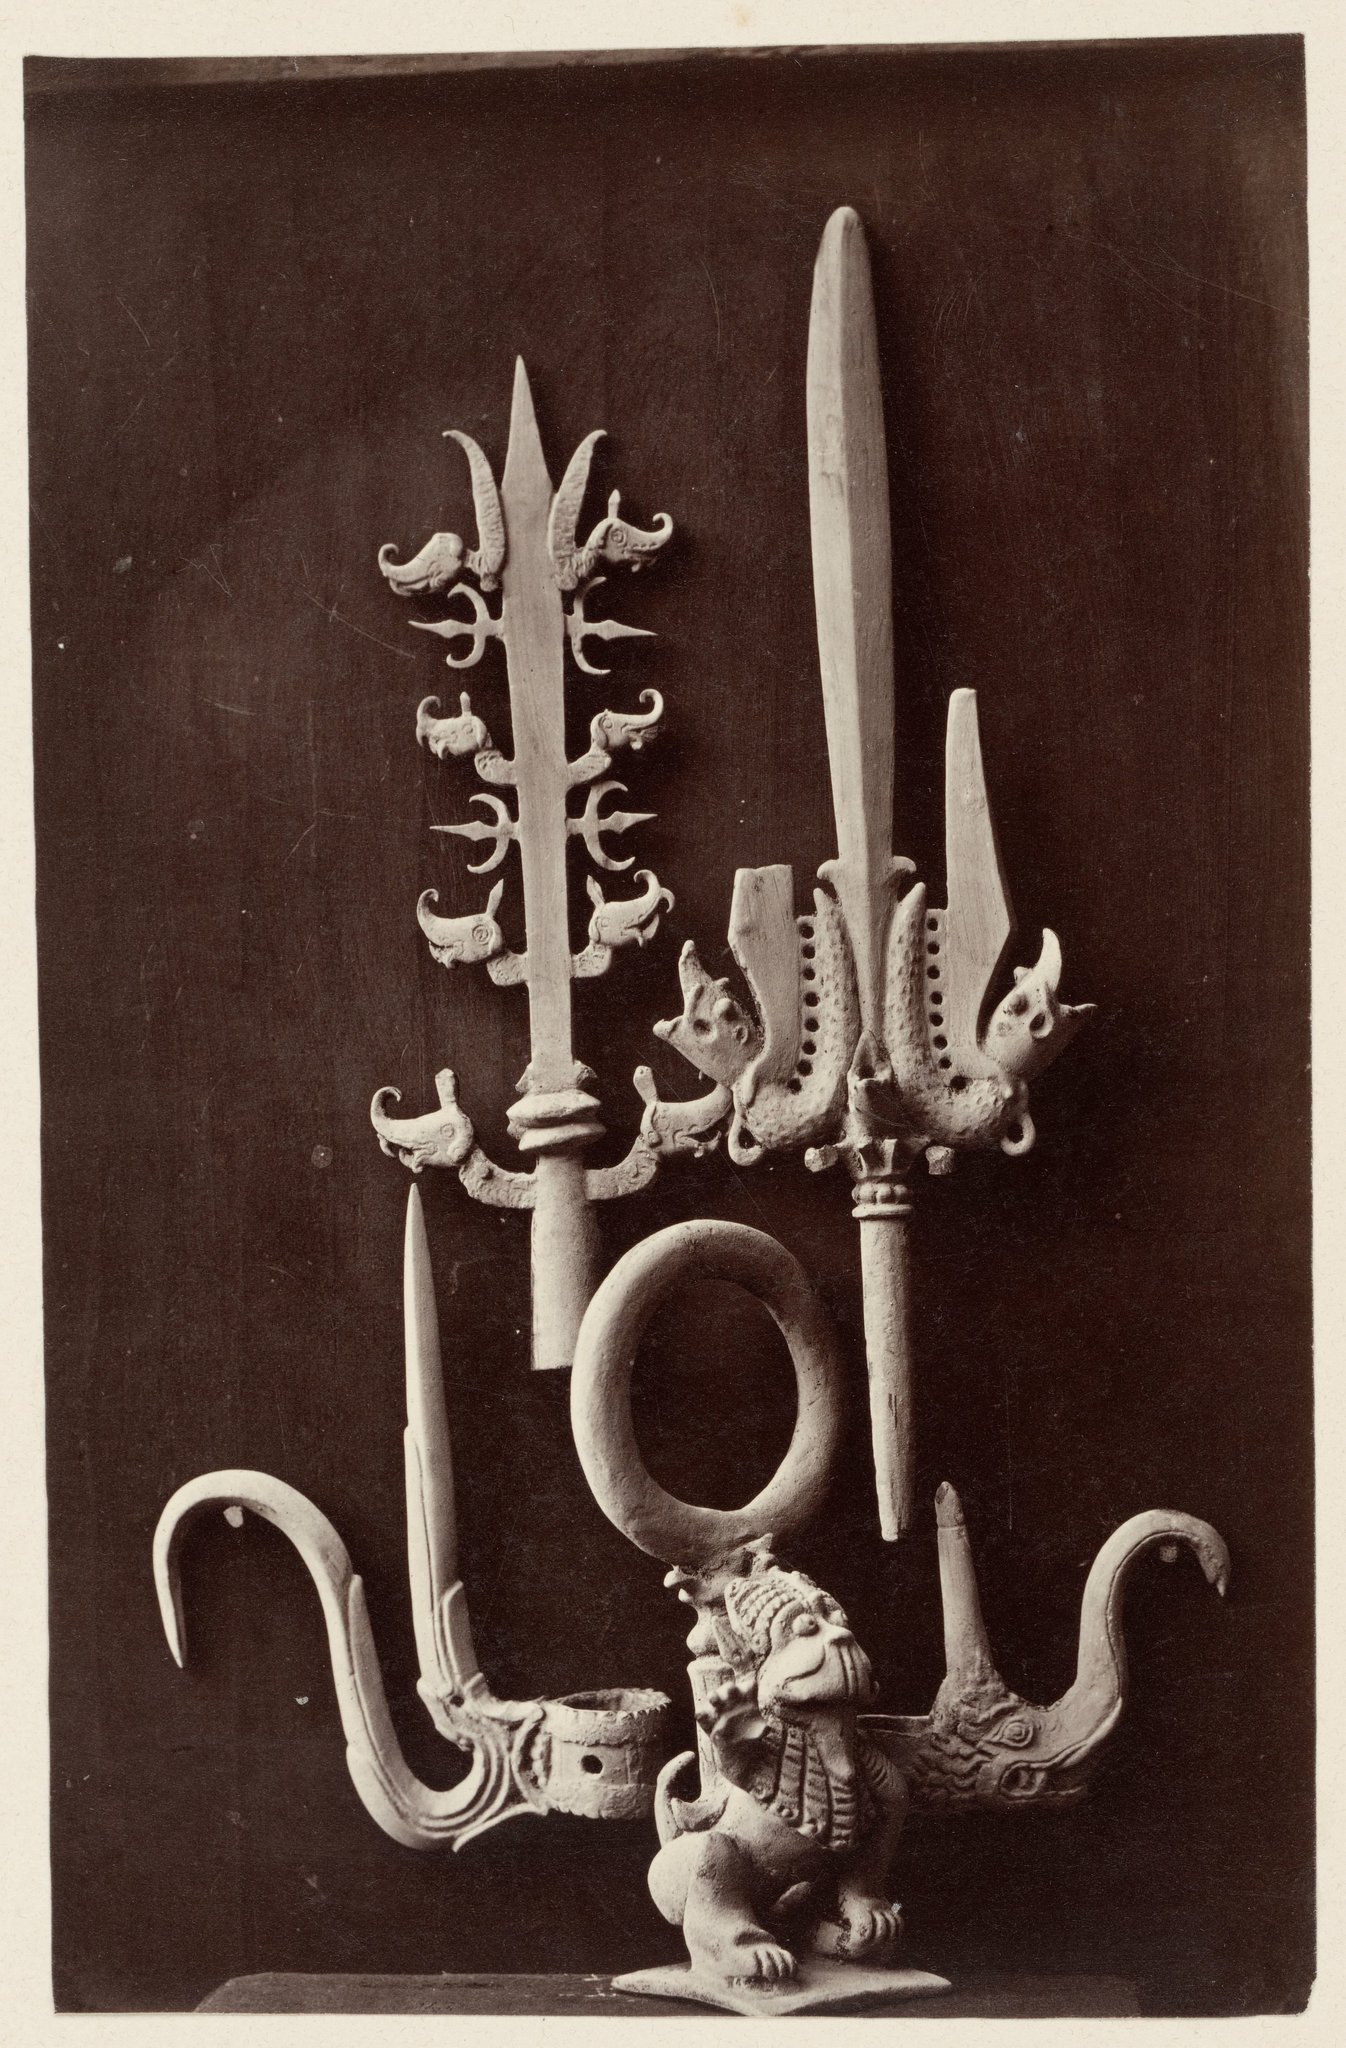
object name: photograph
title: Ritual implements including a finial of a processional staff and part of a lion-shaped lamp, Talaga, Cirebon district, West Java province, 16th-18th century, Indonesia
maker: isidore kinsbergen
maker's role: fotograaf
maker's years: 1821-1905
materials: cardboard, paper, photographic support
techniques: albumen print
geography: java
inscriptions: title: ‘Leeuw met ring (Poeriang boentoetan) twee lanspunten en haken Cat. no. 70 te Telaga (Residentie Cheribon)’